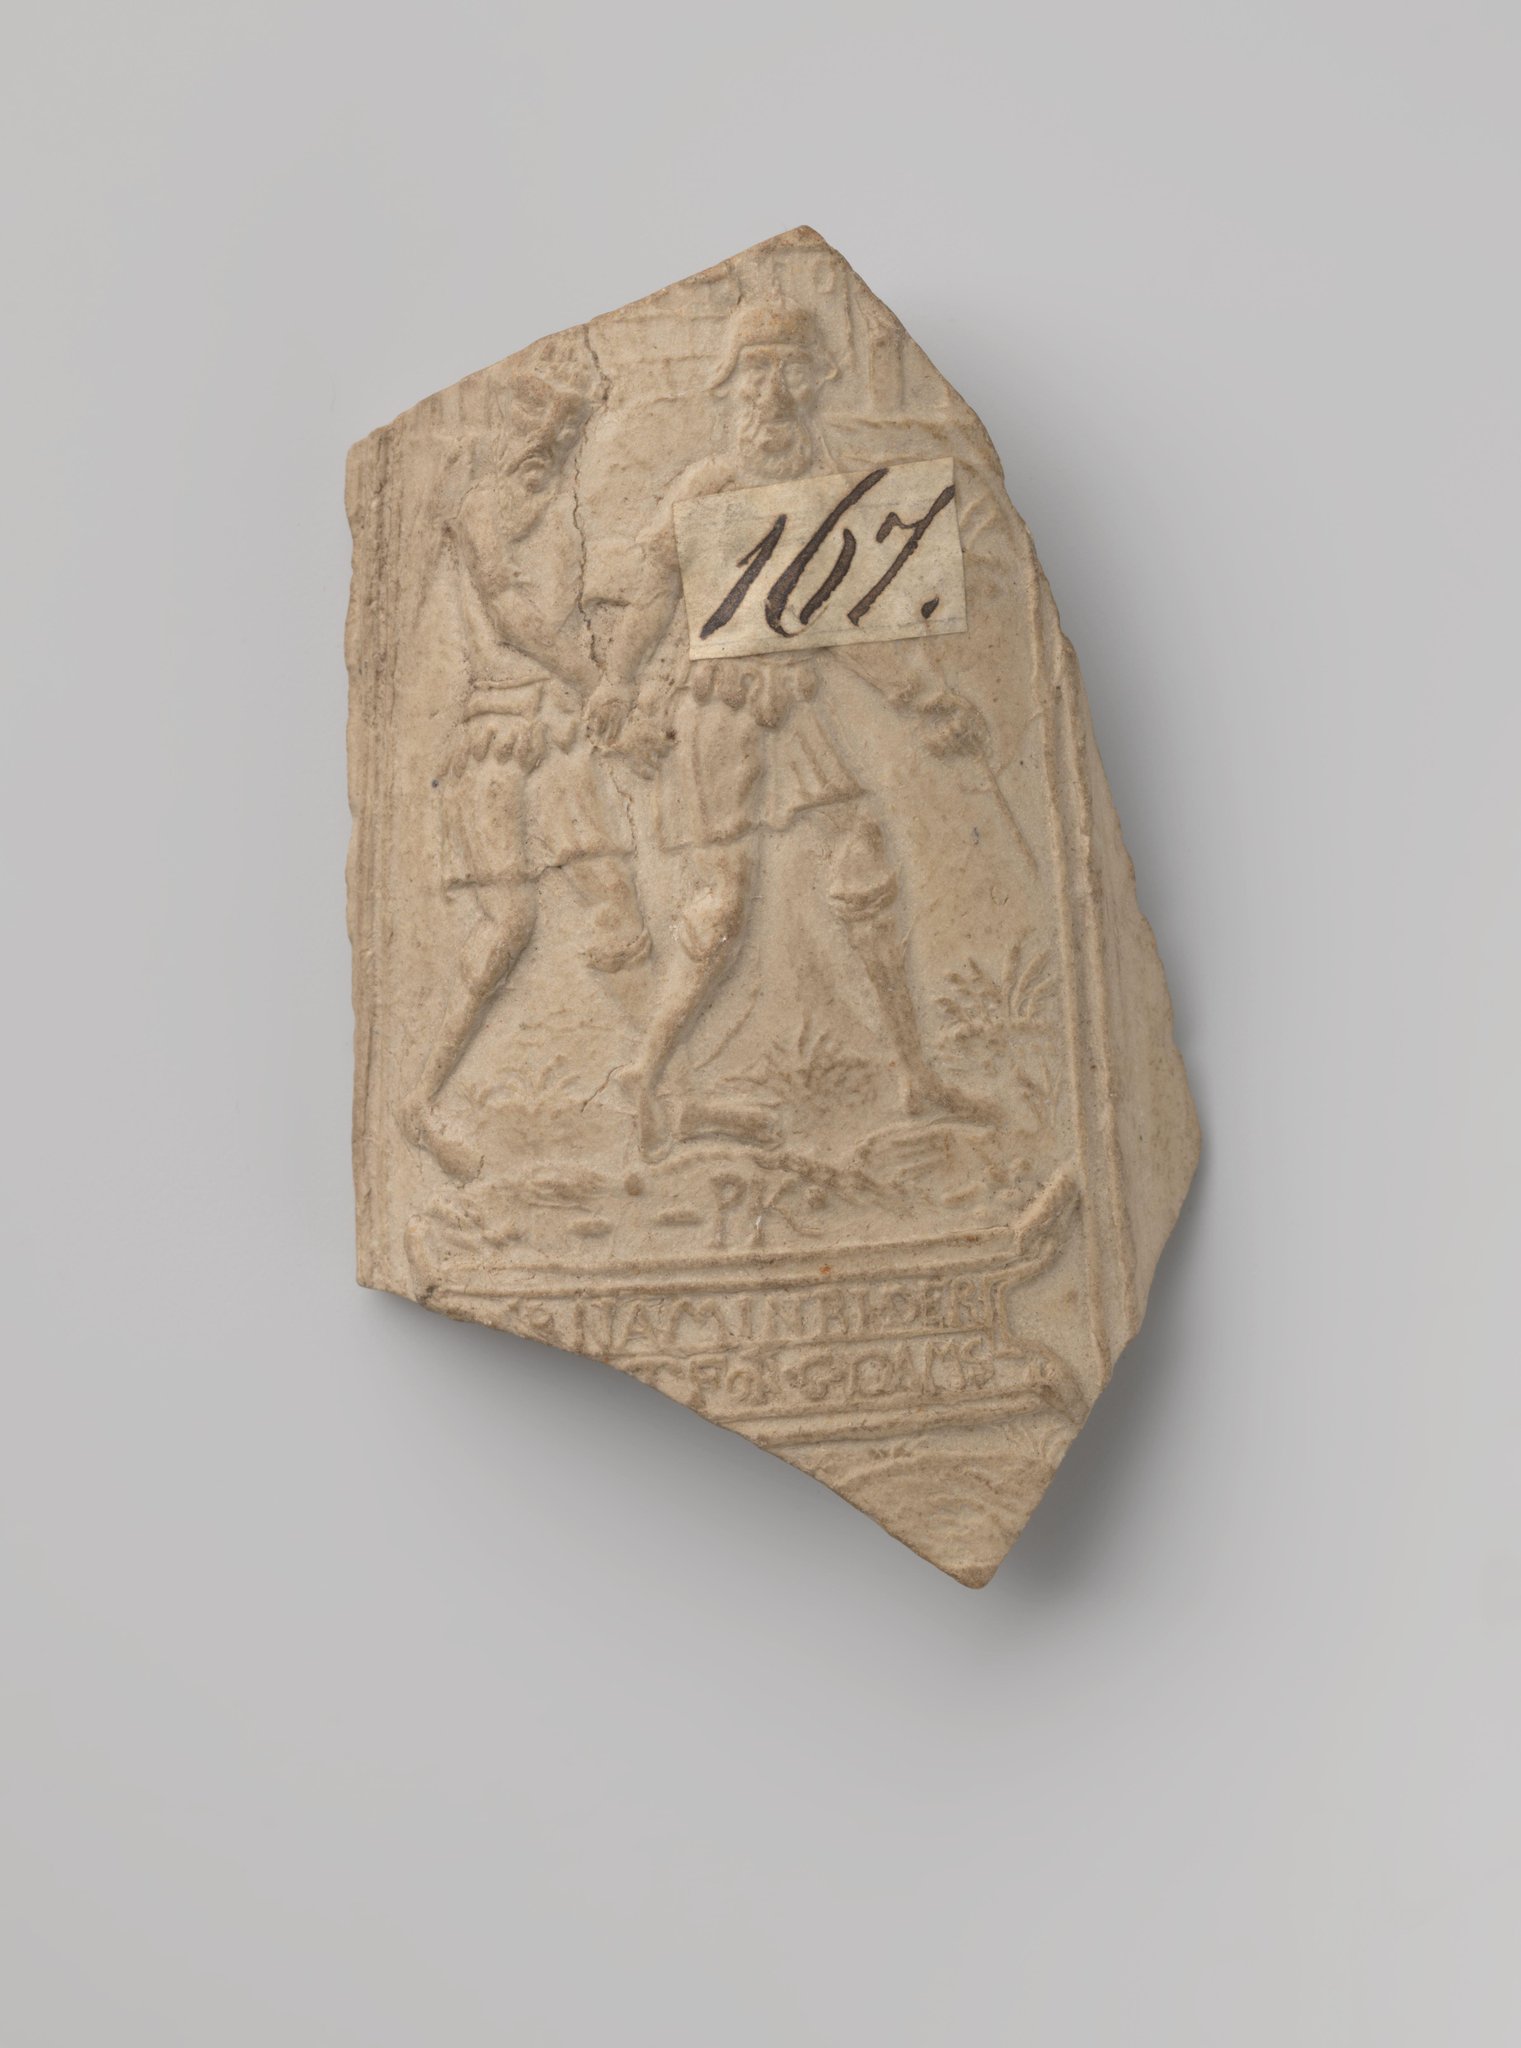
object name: schnelle, snel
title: Fragment of a 'schnelle' tankard with the blind Paul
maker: Anonymous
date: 1570-1600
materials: glaze, stoneware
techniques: firing, forming, relief, turning, vitrification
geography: siegburg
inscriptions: inscription: ‘P.K.’, inscription: ‘[...] NAM IN BI DER [...] DAMS’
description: Fragment van een kruik (schnelle) van steengoed. Op de scherf in reliëf een voorstelling van de blinde Paulus die Damascus wordt binnengevoerd door een soldaat. Onderin het tafereel de letter 'P.K.'. Daaronder een vak met het opschrift '[...] NAM IN BI DER [...] DAMS'. Siegburg.